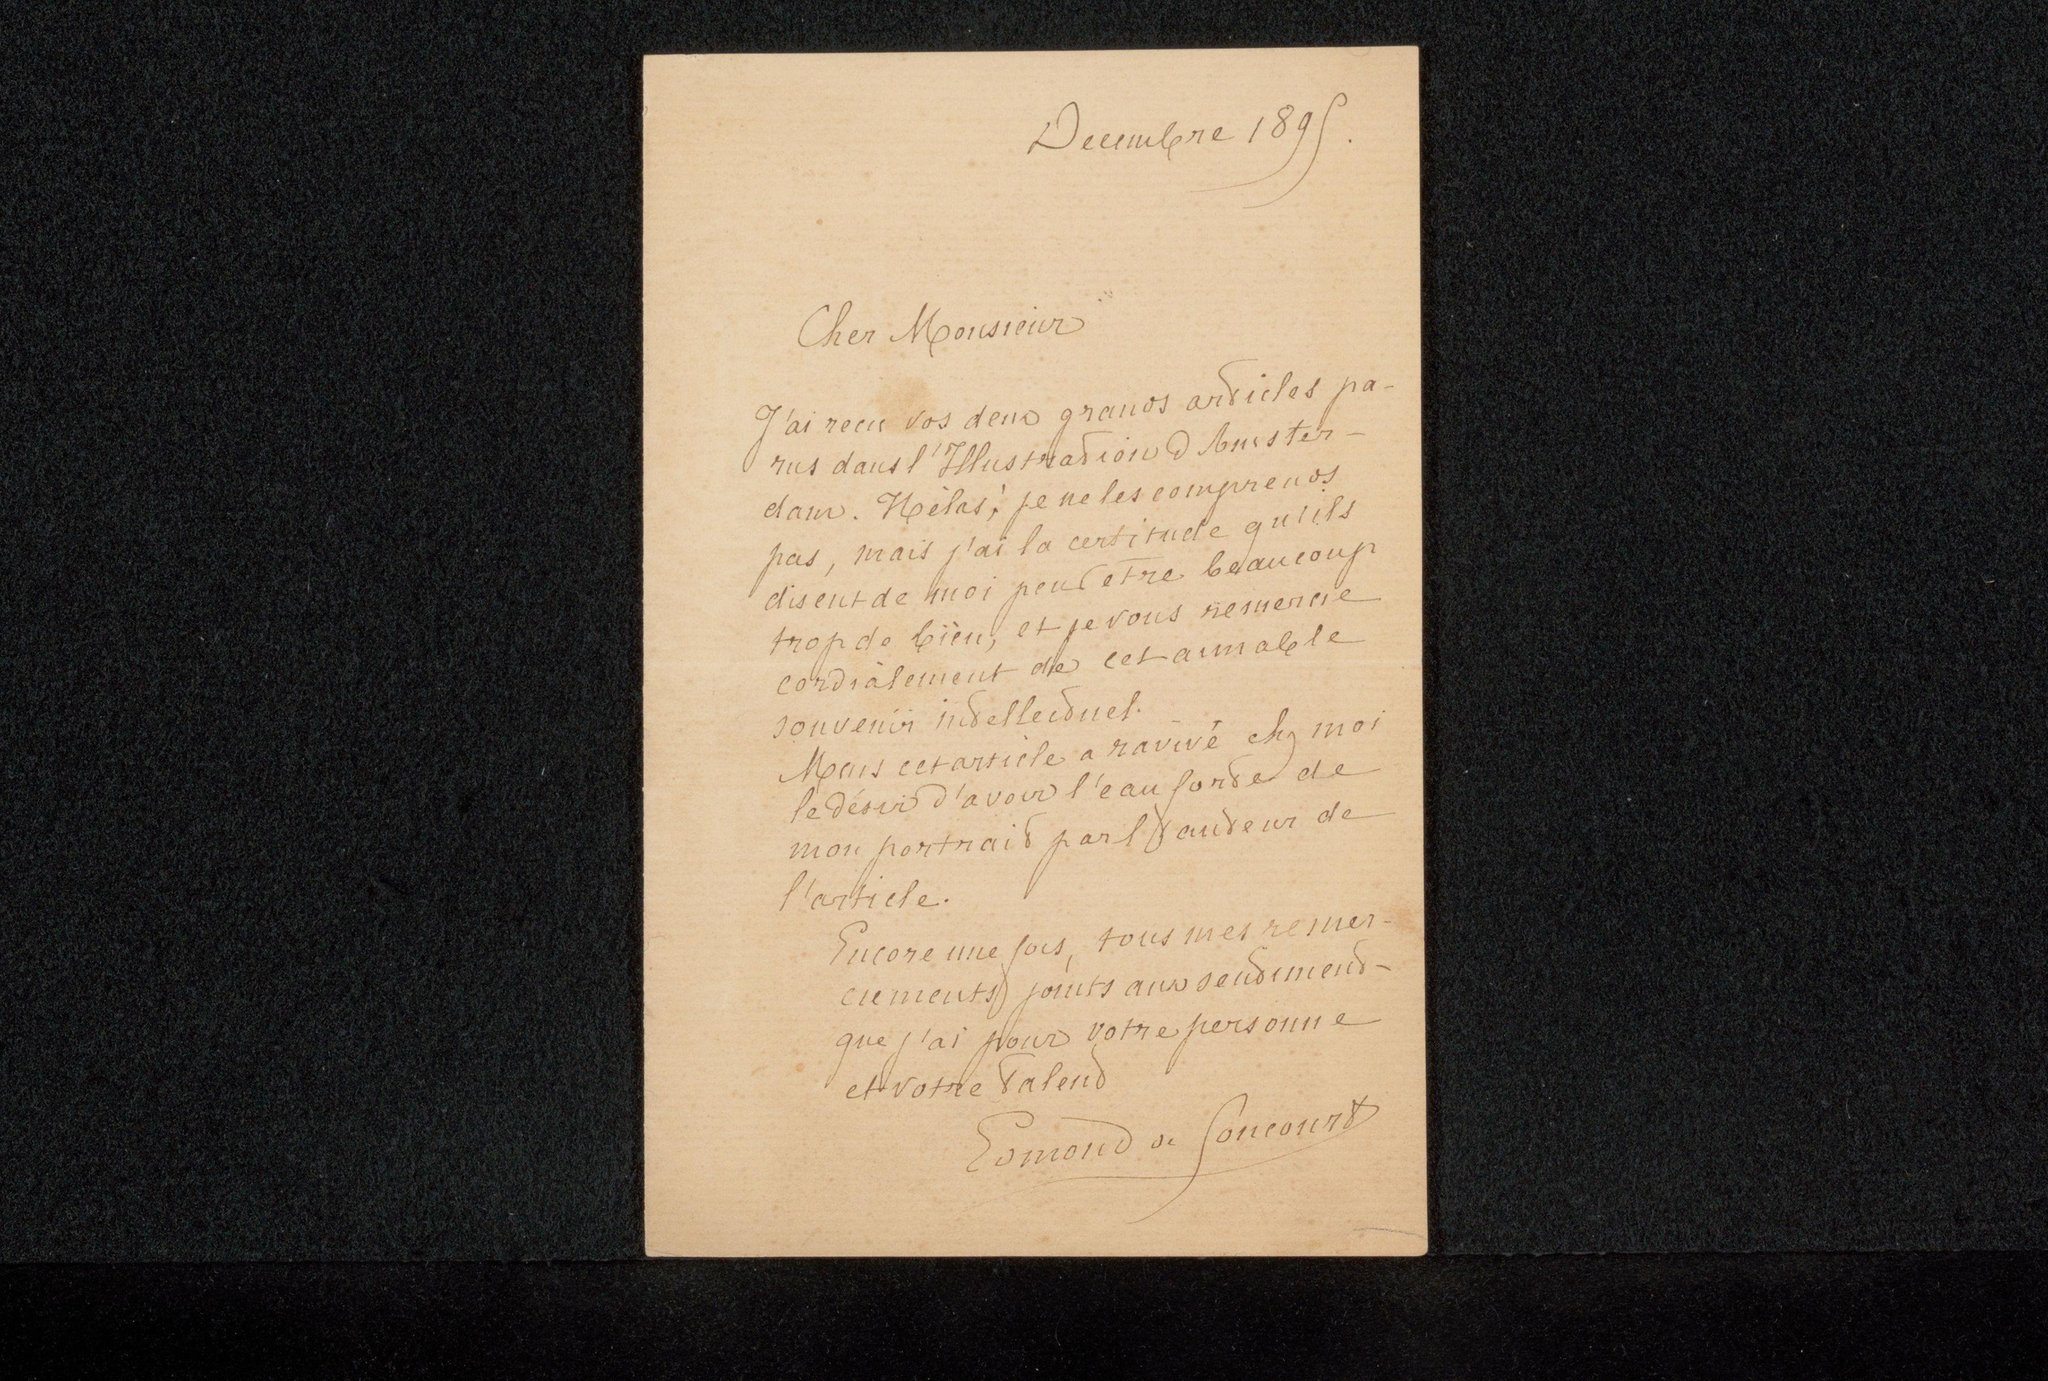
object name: letter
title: Brief aan Philip Zilcken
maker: edmond de goncourt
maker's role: draughtsman, painter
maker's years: 1822-1896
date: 1812-1895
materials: ink, paper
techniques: pen, writing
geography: auteuil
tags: painter, draughtsman, edmond de goncourt, the hague, philip zilcken, the graphic arts, historical persons (portraits and scenes from the life)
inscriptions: collector's mark: ‘RPK’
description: Transcriptie van de brief wordt bewaard bij RP-D-1982-43-GONCOURT(EDMONDDE)-7.